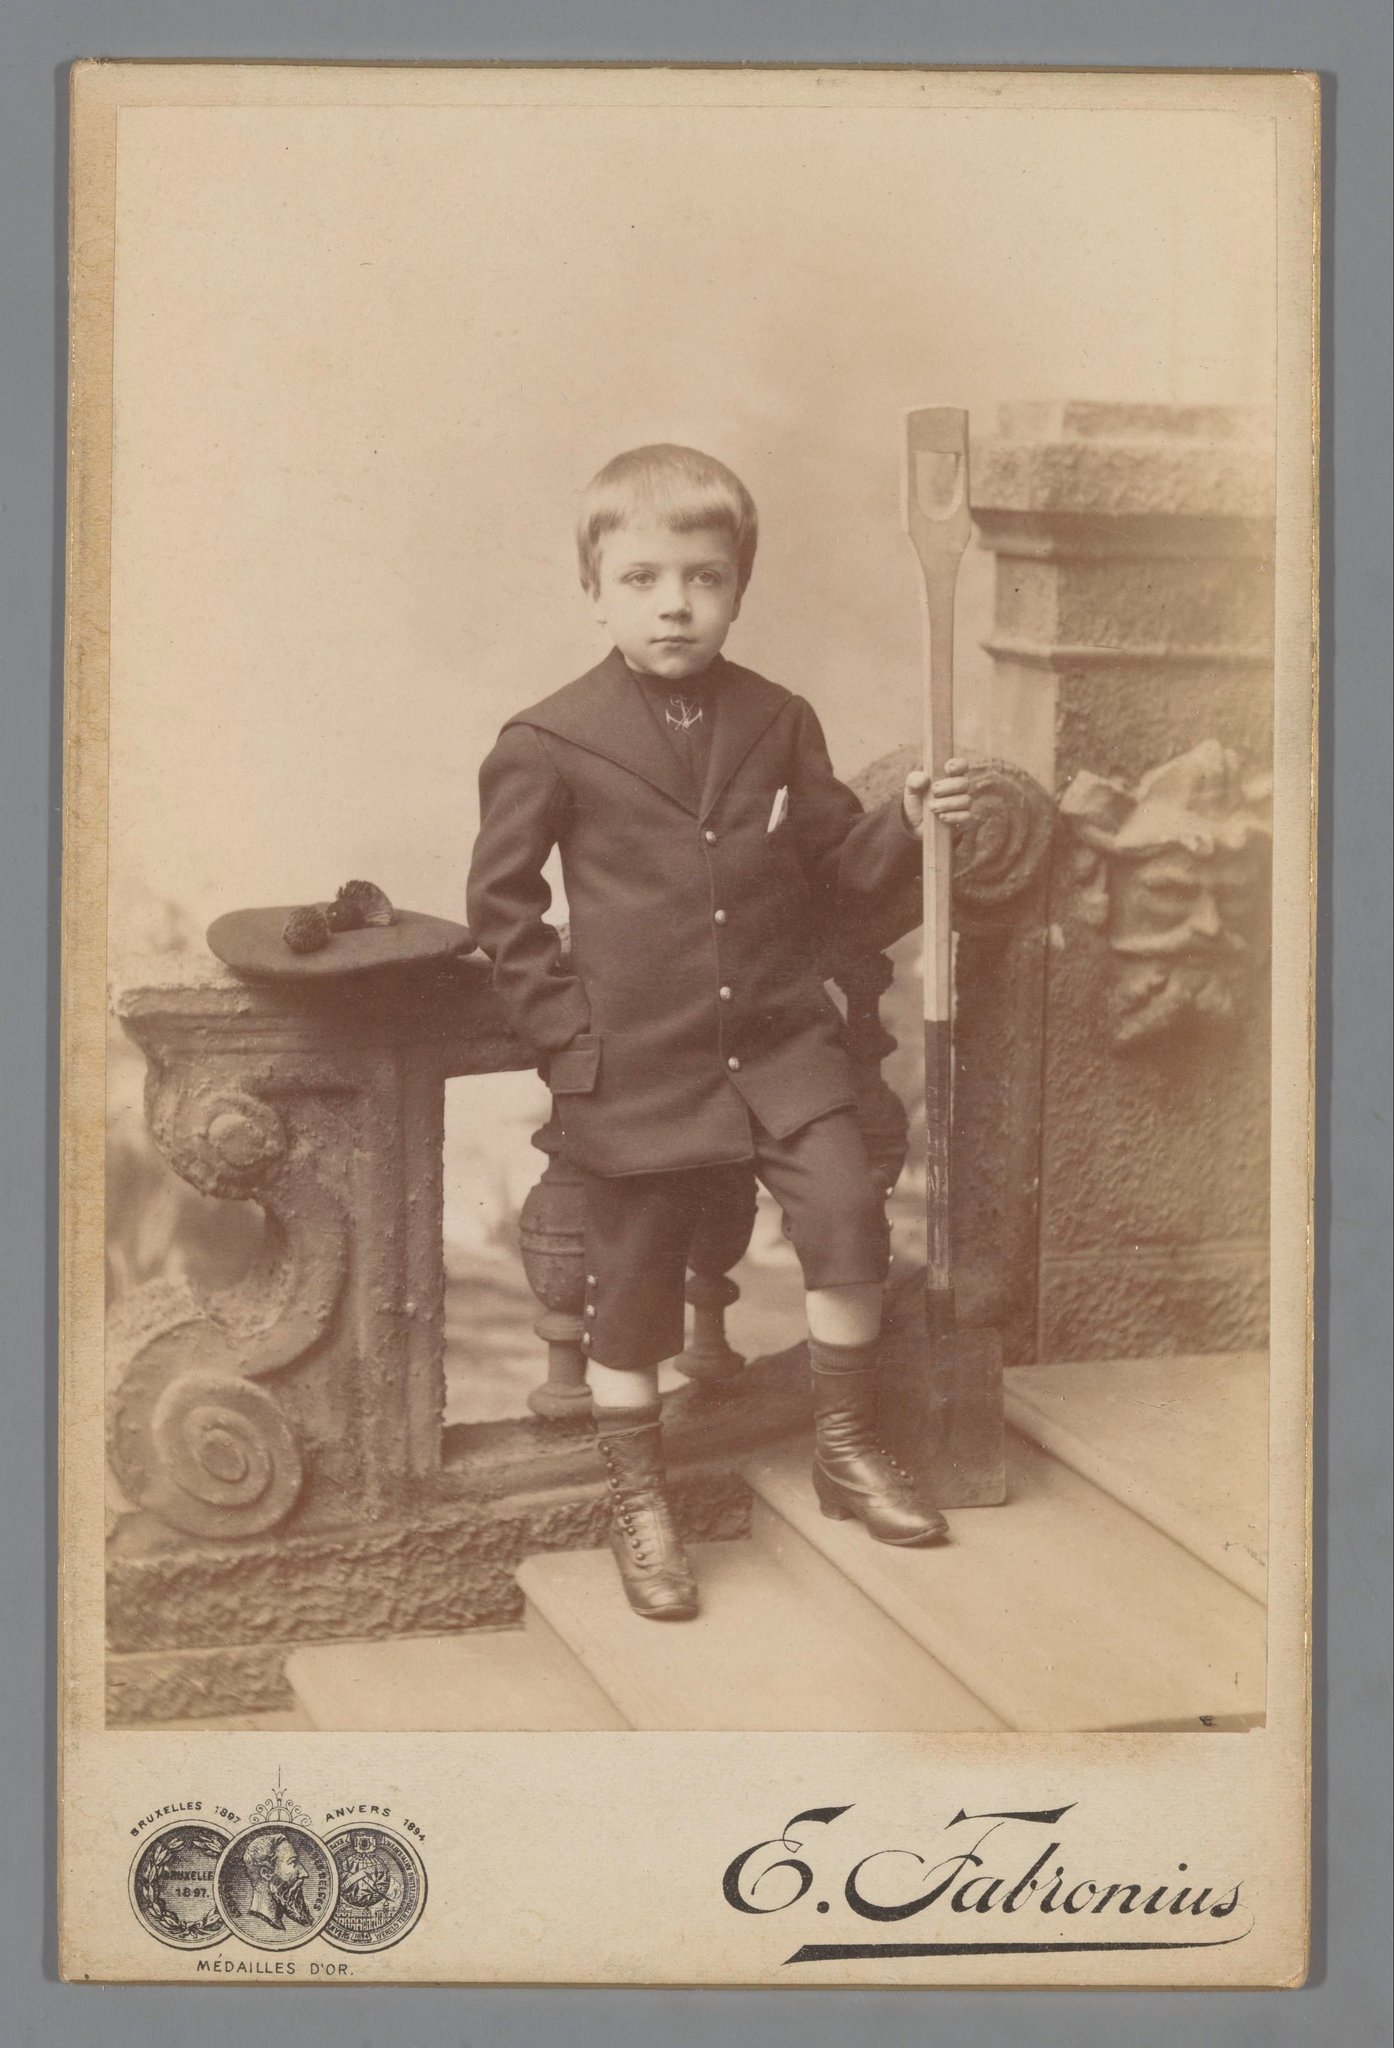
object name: cabinet photograph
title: Portret van een jongen met een schop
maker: edouard fabronius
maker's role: fotograaf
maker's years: 1847-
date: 1897-1901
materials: cardboard, photographic support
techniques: albumen print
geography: brussels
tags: boy (child between toddler and youth), agricultural implements: spade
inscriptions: name: ‘E. Fabronius 11 Rue Neuve Bruxelles.’